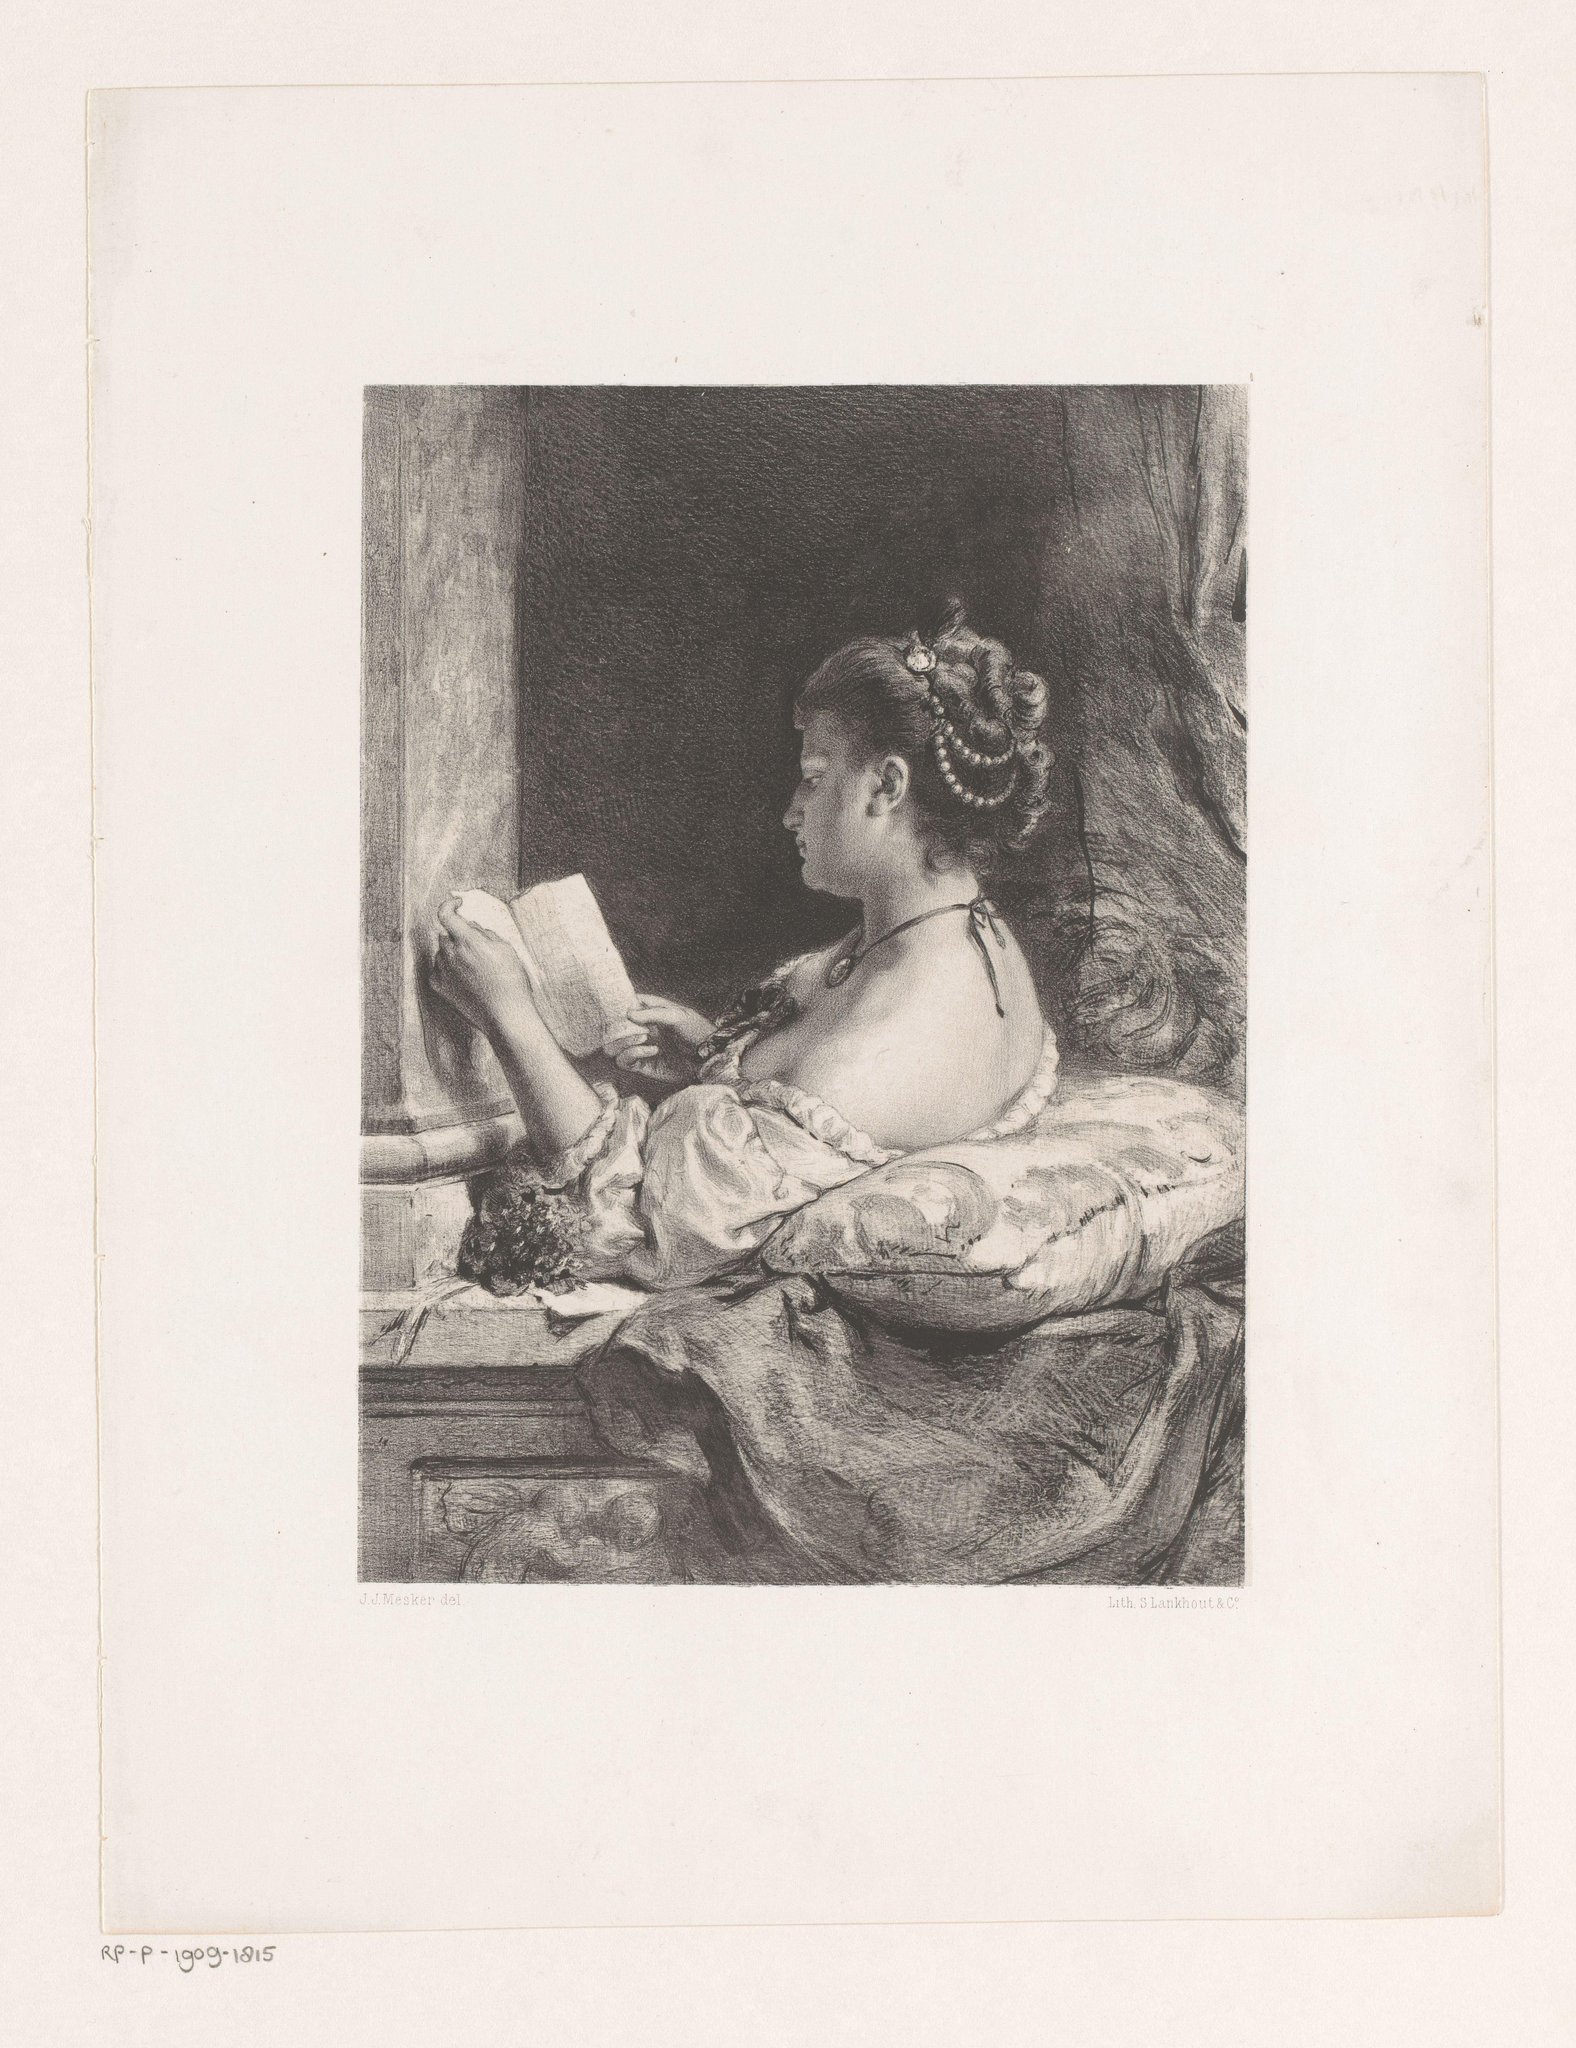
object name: print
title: Lezende vrouw op balkon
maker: jan mesker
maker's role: print maker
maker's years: 1843-1890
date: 1877-1890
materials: paper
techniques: lithograph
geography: the hague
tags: adult woman, reading, balcony, pillow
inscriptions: collector's mark: Lugt 2228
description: De vrouw leunt op een kussen. Naast haar ligt een bloem. Ze draagt een jurk met ontblote schouders.